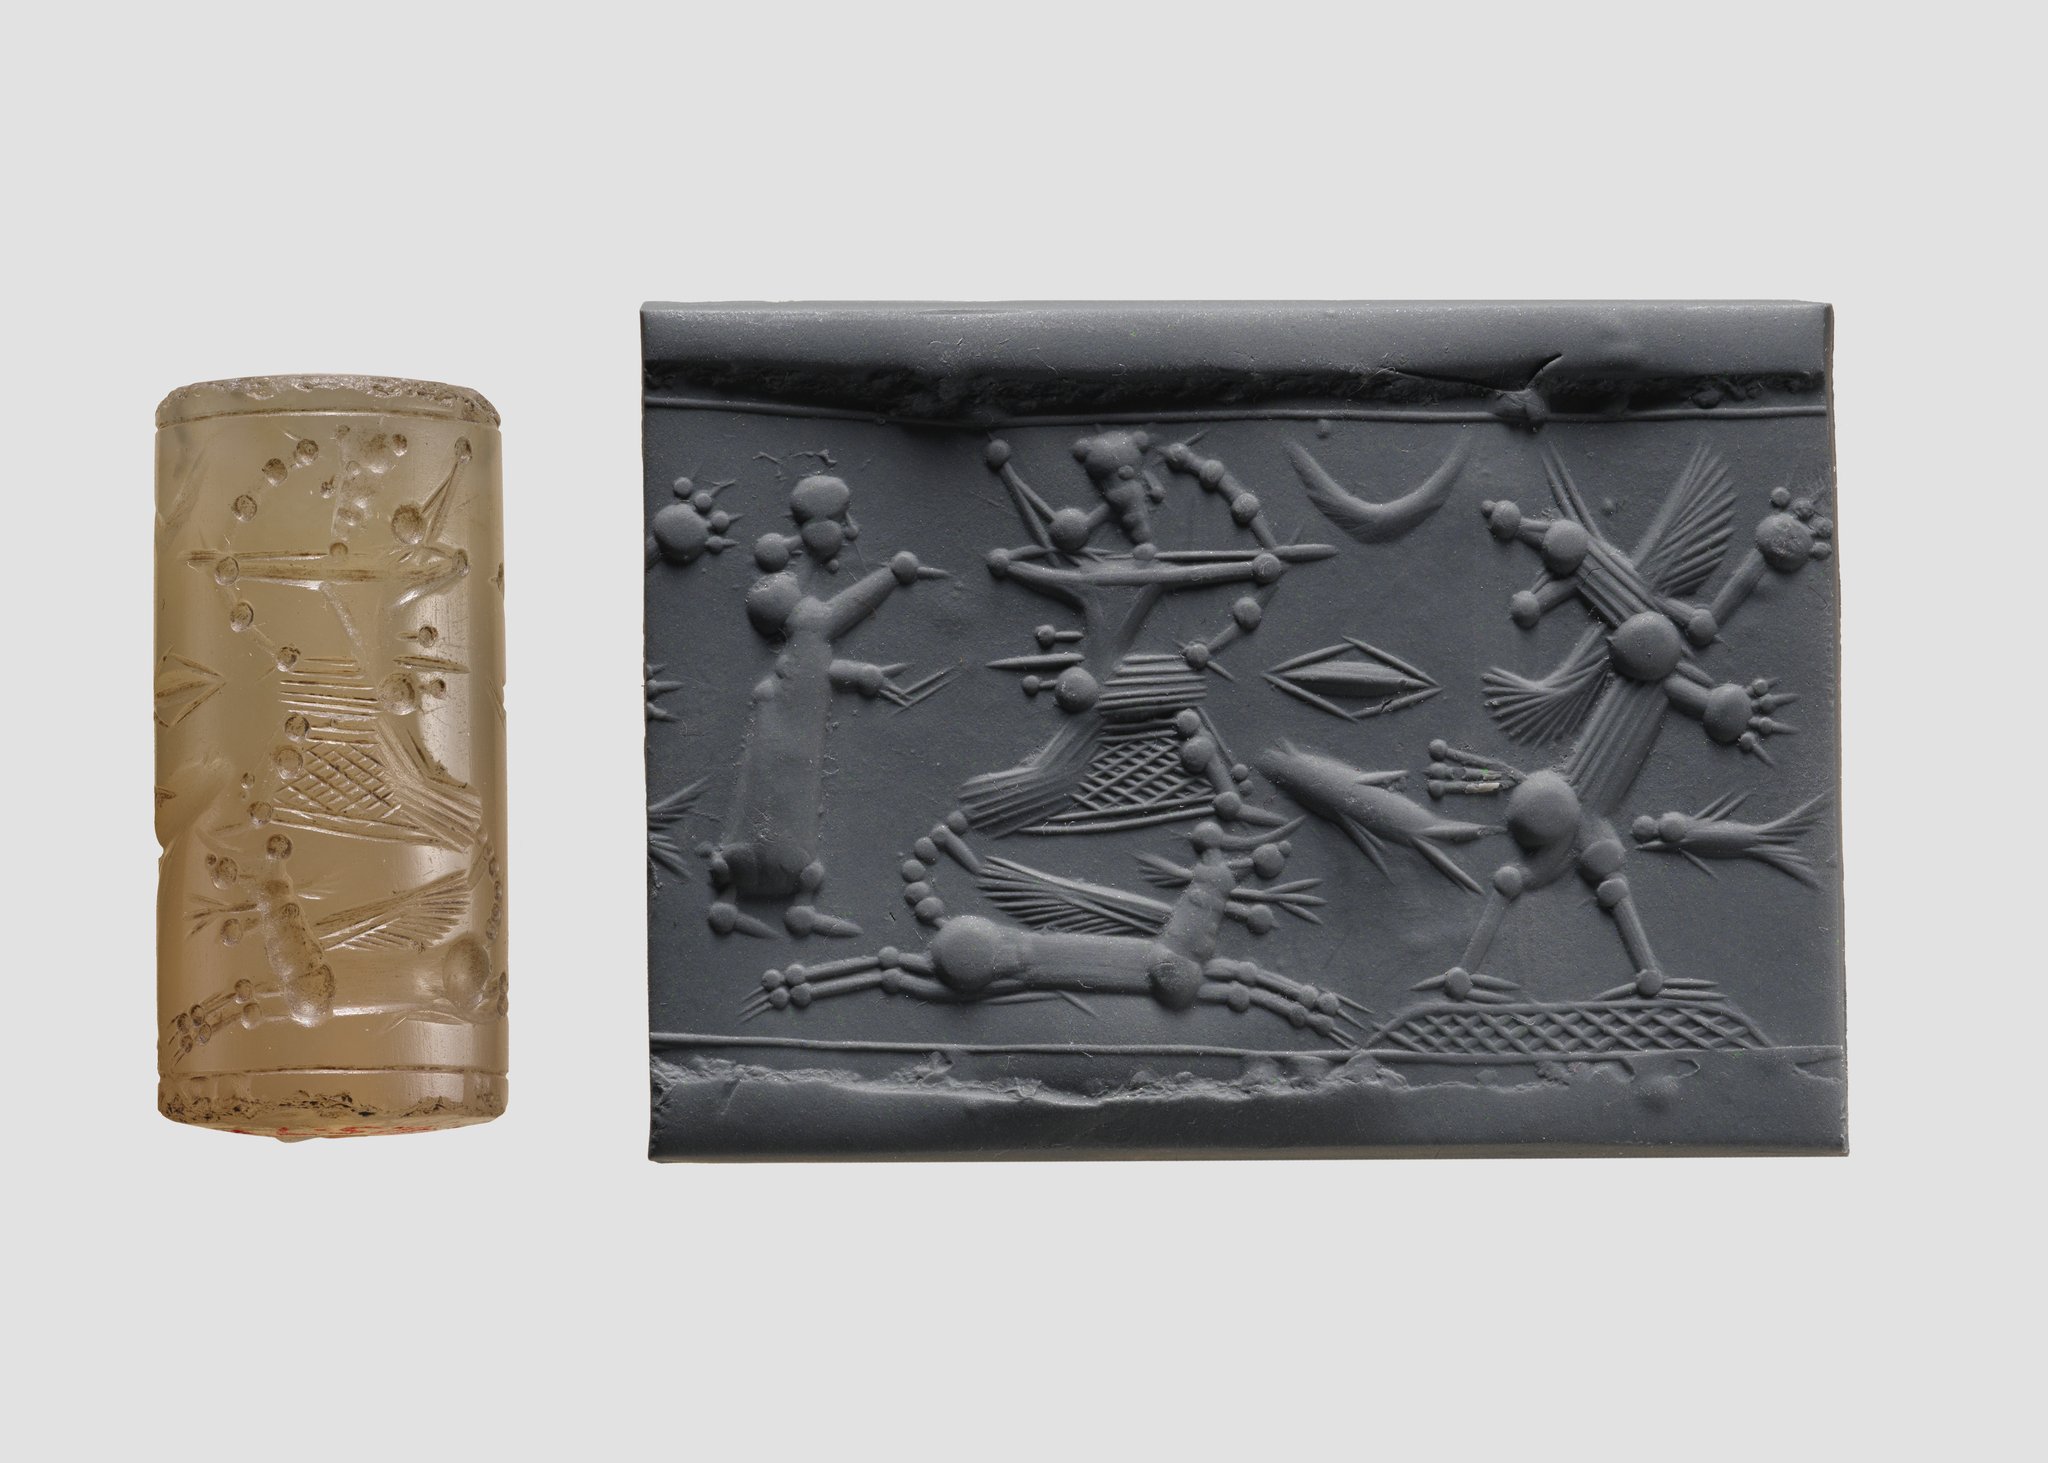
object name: cylinder seal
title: Cylinder seal with mythological contest scene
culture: assyrian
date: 834-701 BCE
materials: stone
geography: mesopotamia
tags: griffins